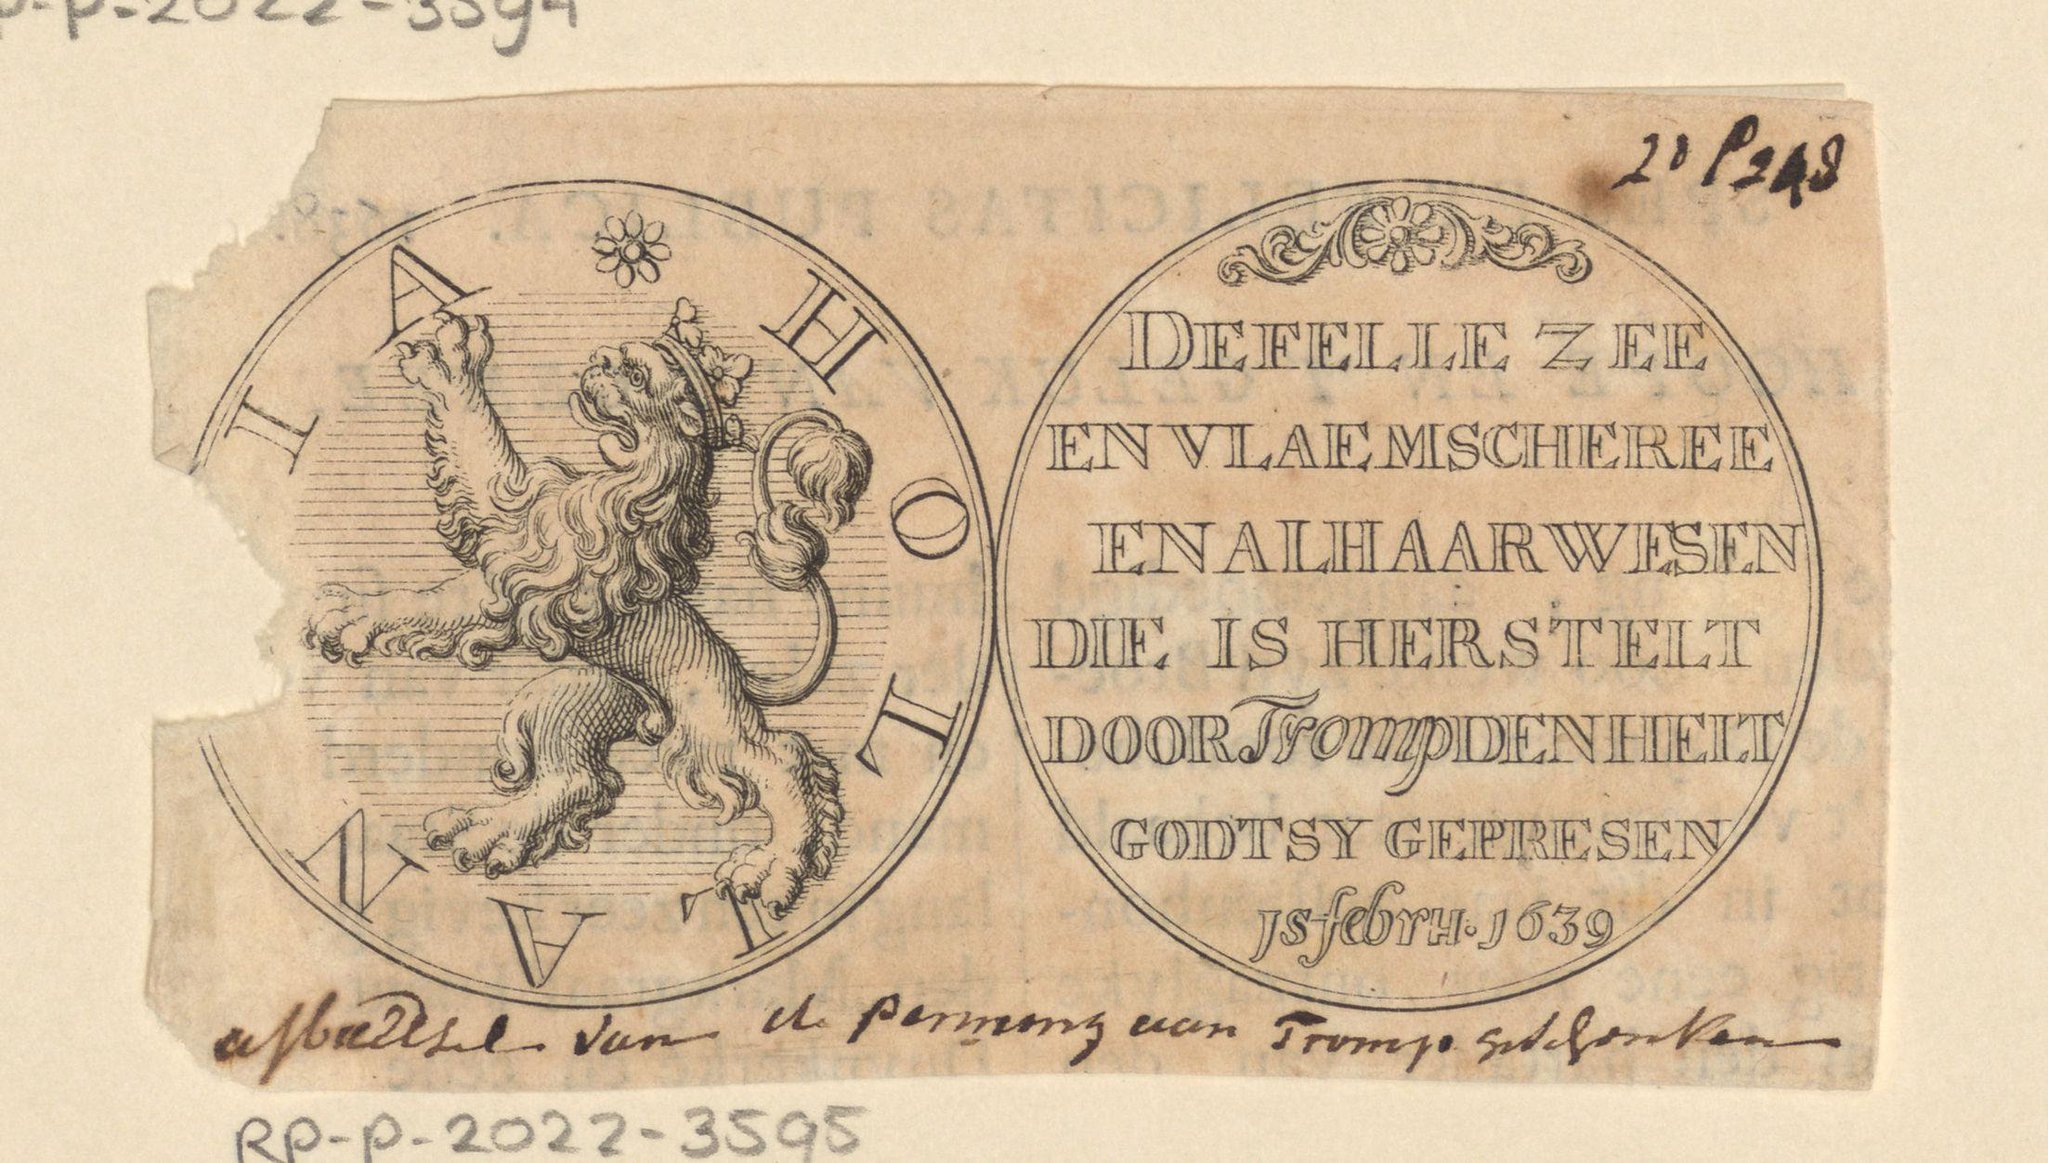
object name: print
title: Voor- en achterzijde van een penning over Maarten Hapertszoon Tromp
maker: Anonymous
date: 1726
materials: paper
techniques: etching, letterpress printing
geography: northern netherlands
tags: pendant, trinket, 'breloque'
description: Prent uit: Loon, Gerard van. Beschryving der Nederlandsche Historipenningen: (...). Den Haag: Christiaan van Lom et al., 1726, dl. 2, p. 248.